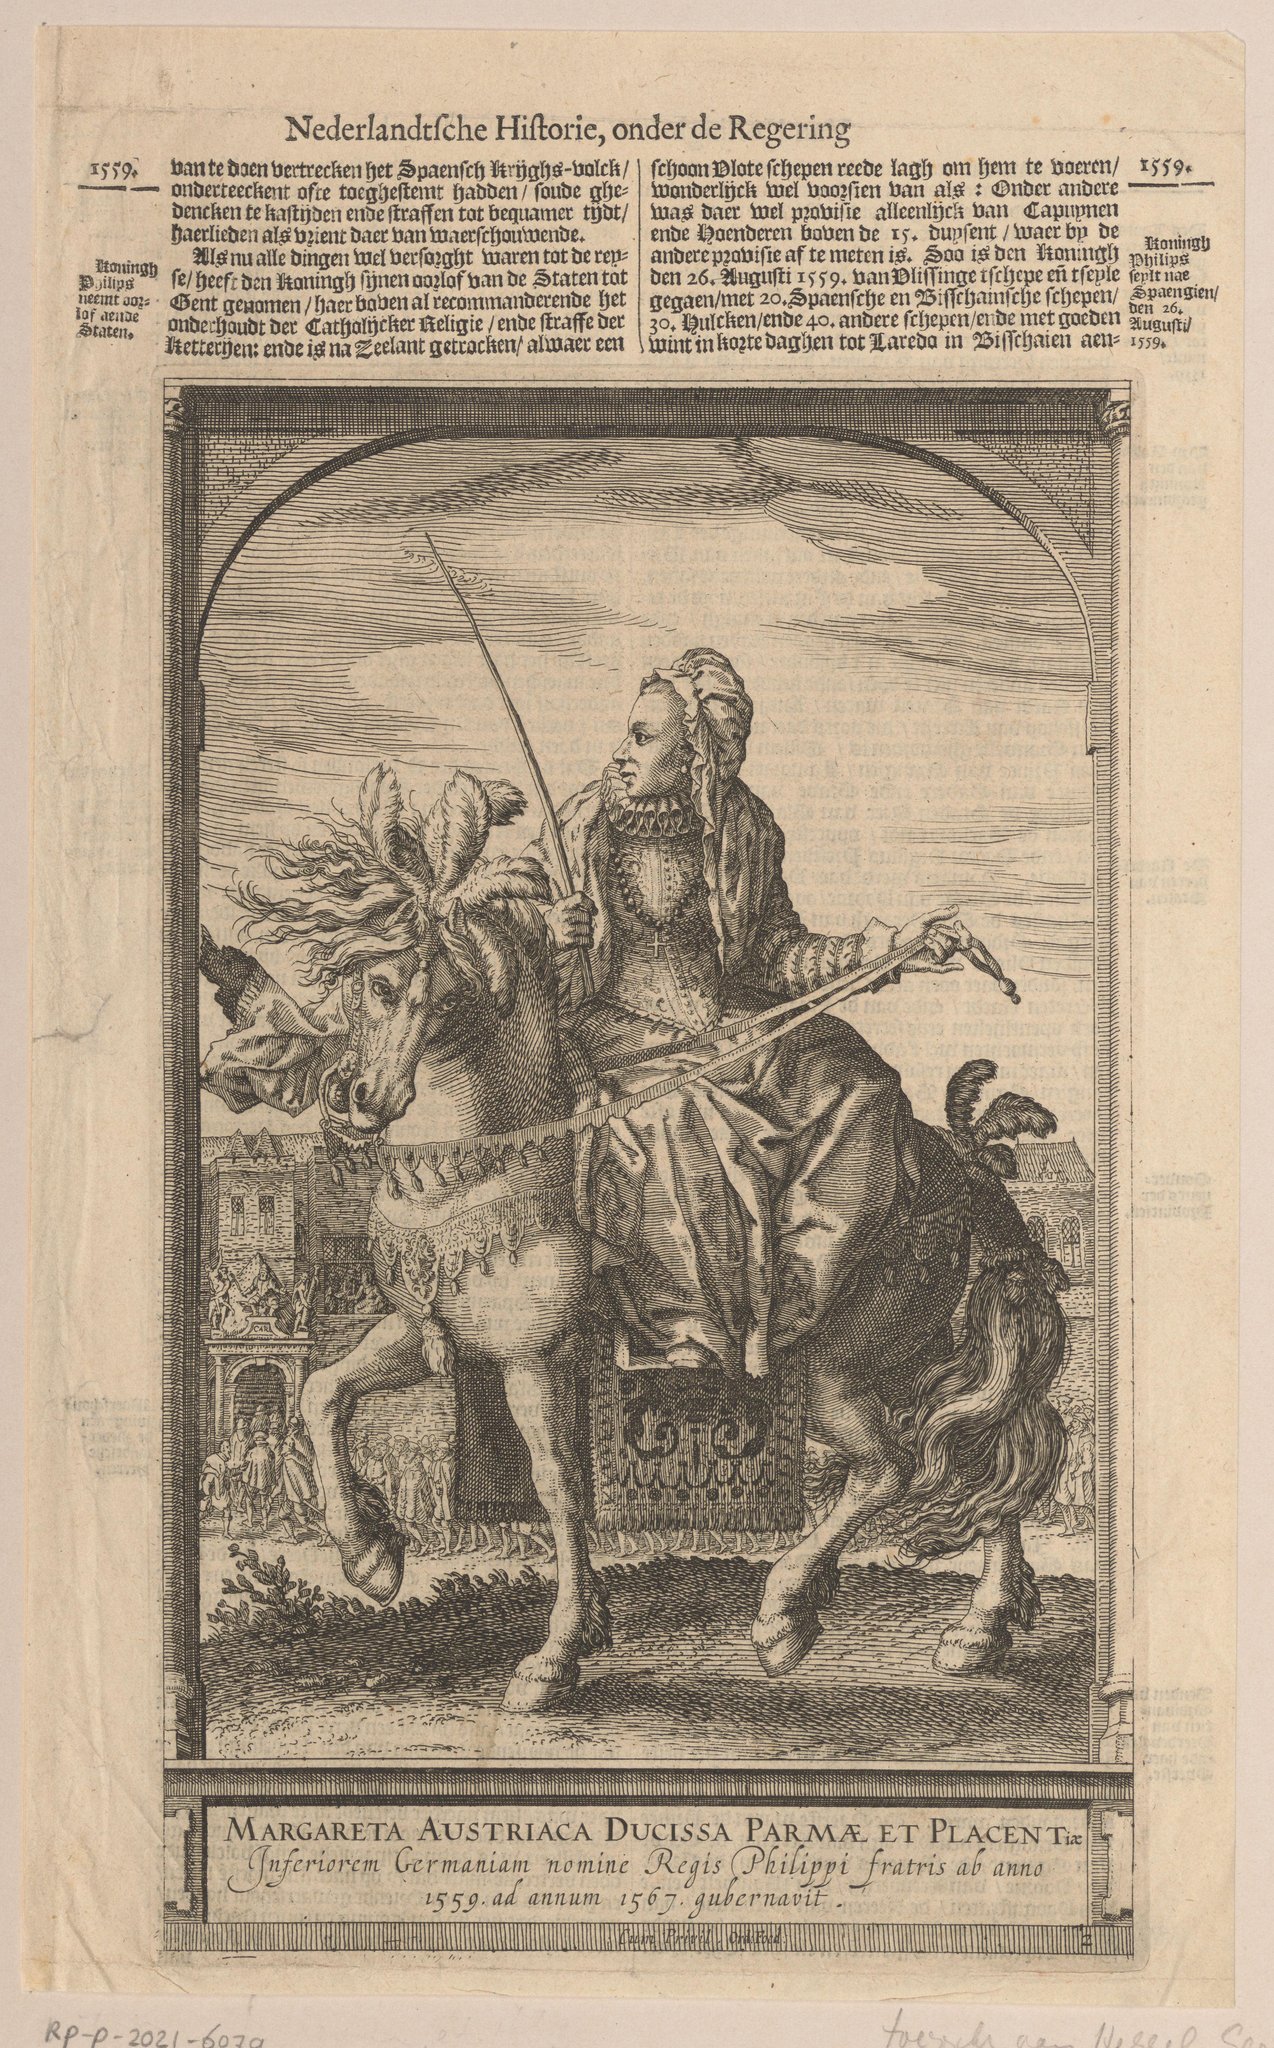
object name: print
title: Ruiterportret van Margaretha van Parma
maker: hessel gerritsz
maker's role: draughtsman, print maker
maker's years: 1581-1632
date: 1647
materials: paper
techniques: etching, letterpress printing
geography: amsterdam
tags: equestrian state-portrait, historical persons - bb - woman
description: Bladzijde uit: Meteren, Emanuel van. Historien der Nederlanden, en haar naburen oorlogen tot het Iaar 1612. Rotterdam: Pieter van Waesberge, 1647, p. 25. Prent ook gebruikt in de edities uit 1652 en 1663.